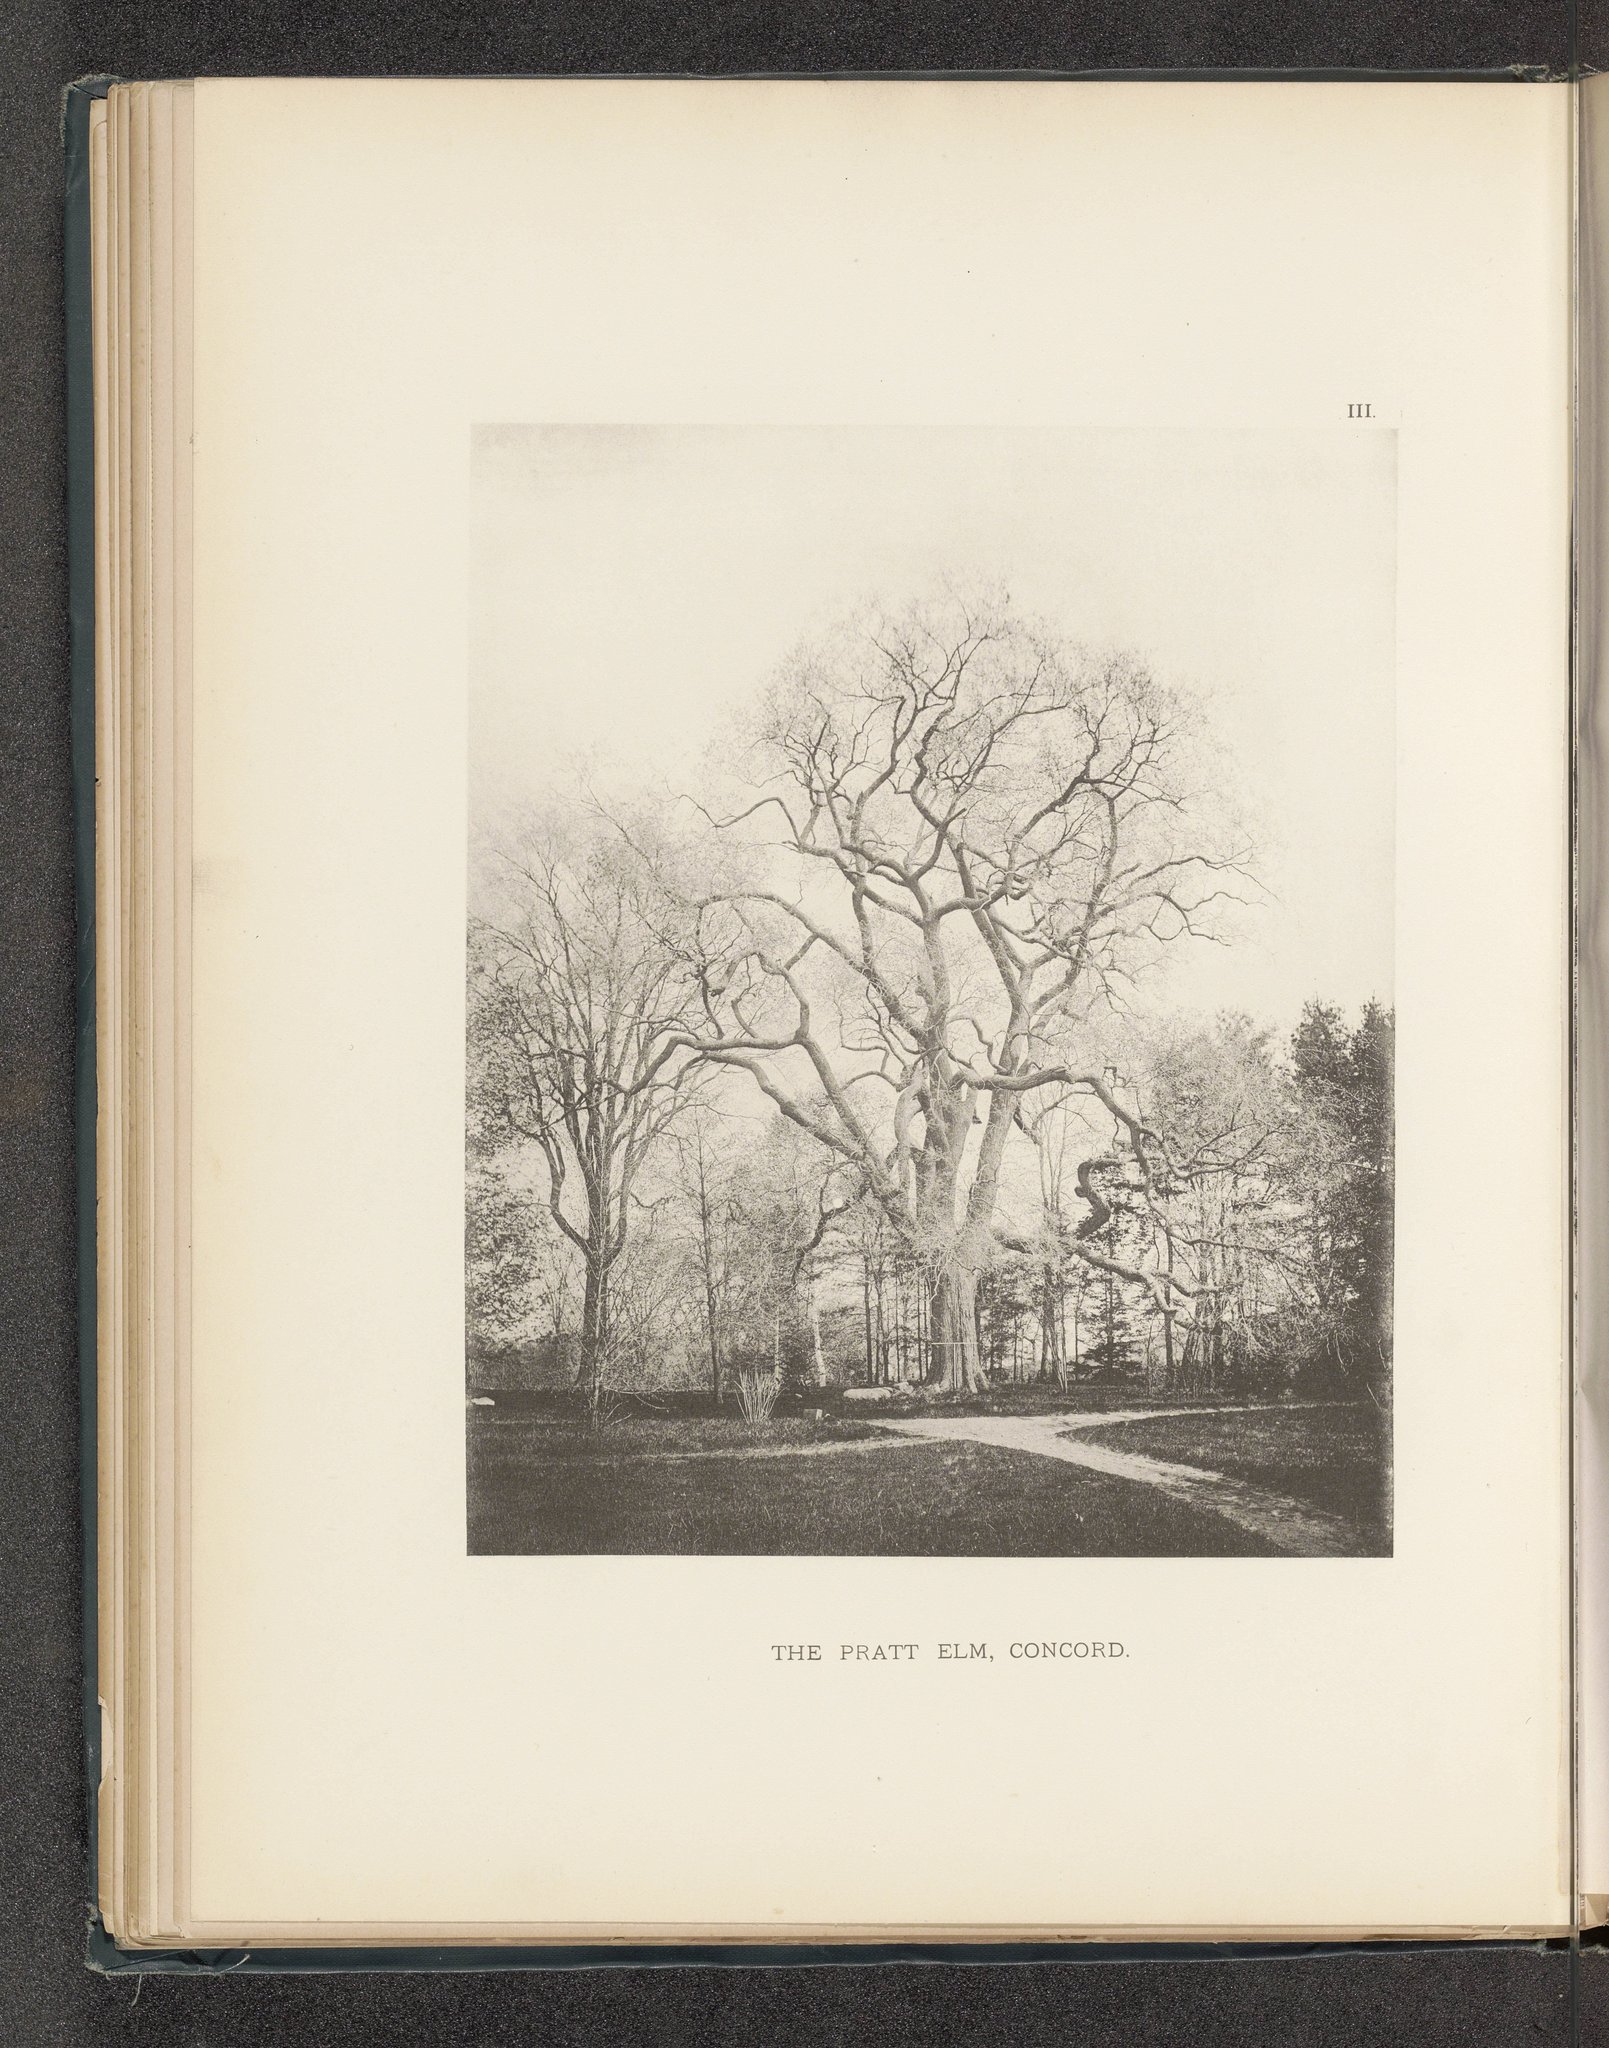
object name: page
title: The pratt elm, Concord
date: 1880-1890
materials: paper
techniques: photograph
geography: concord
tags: trees: elm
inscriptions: number: ‘III.’